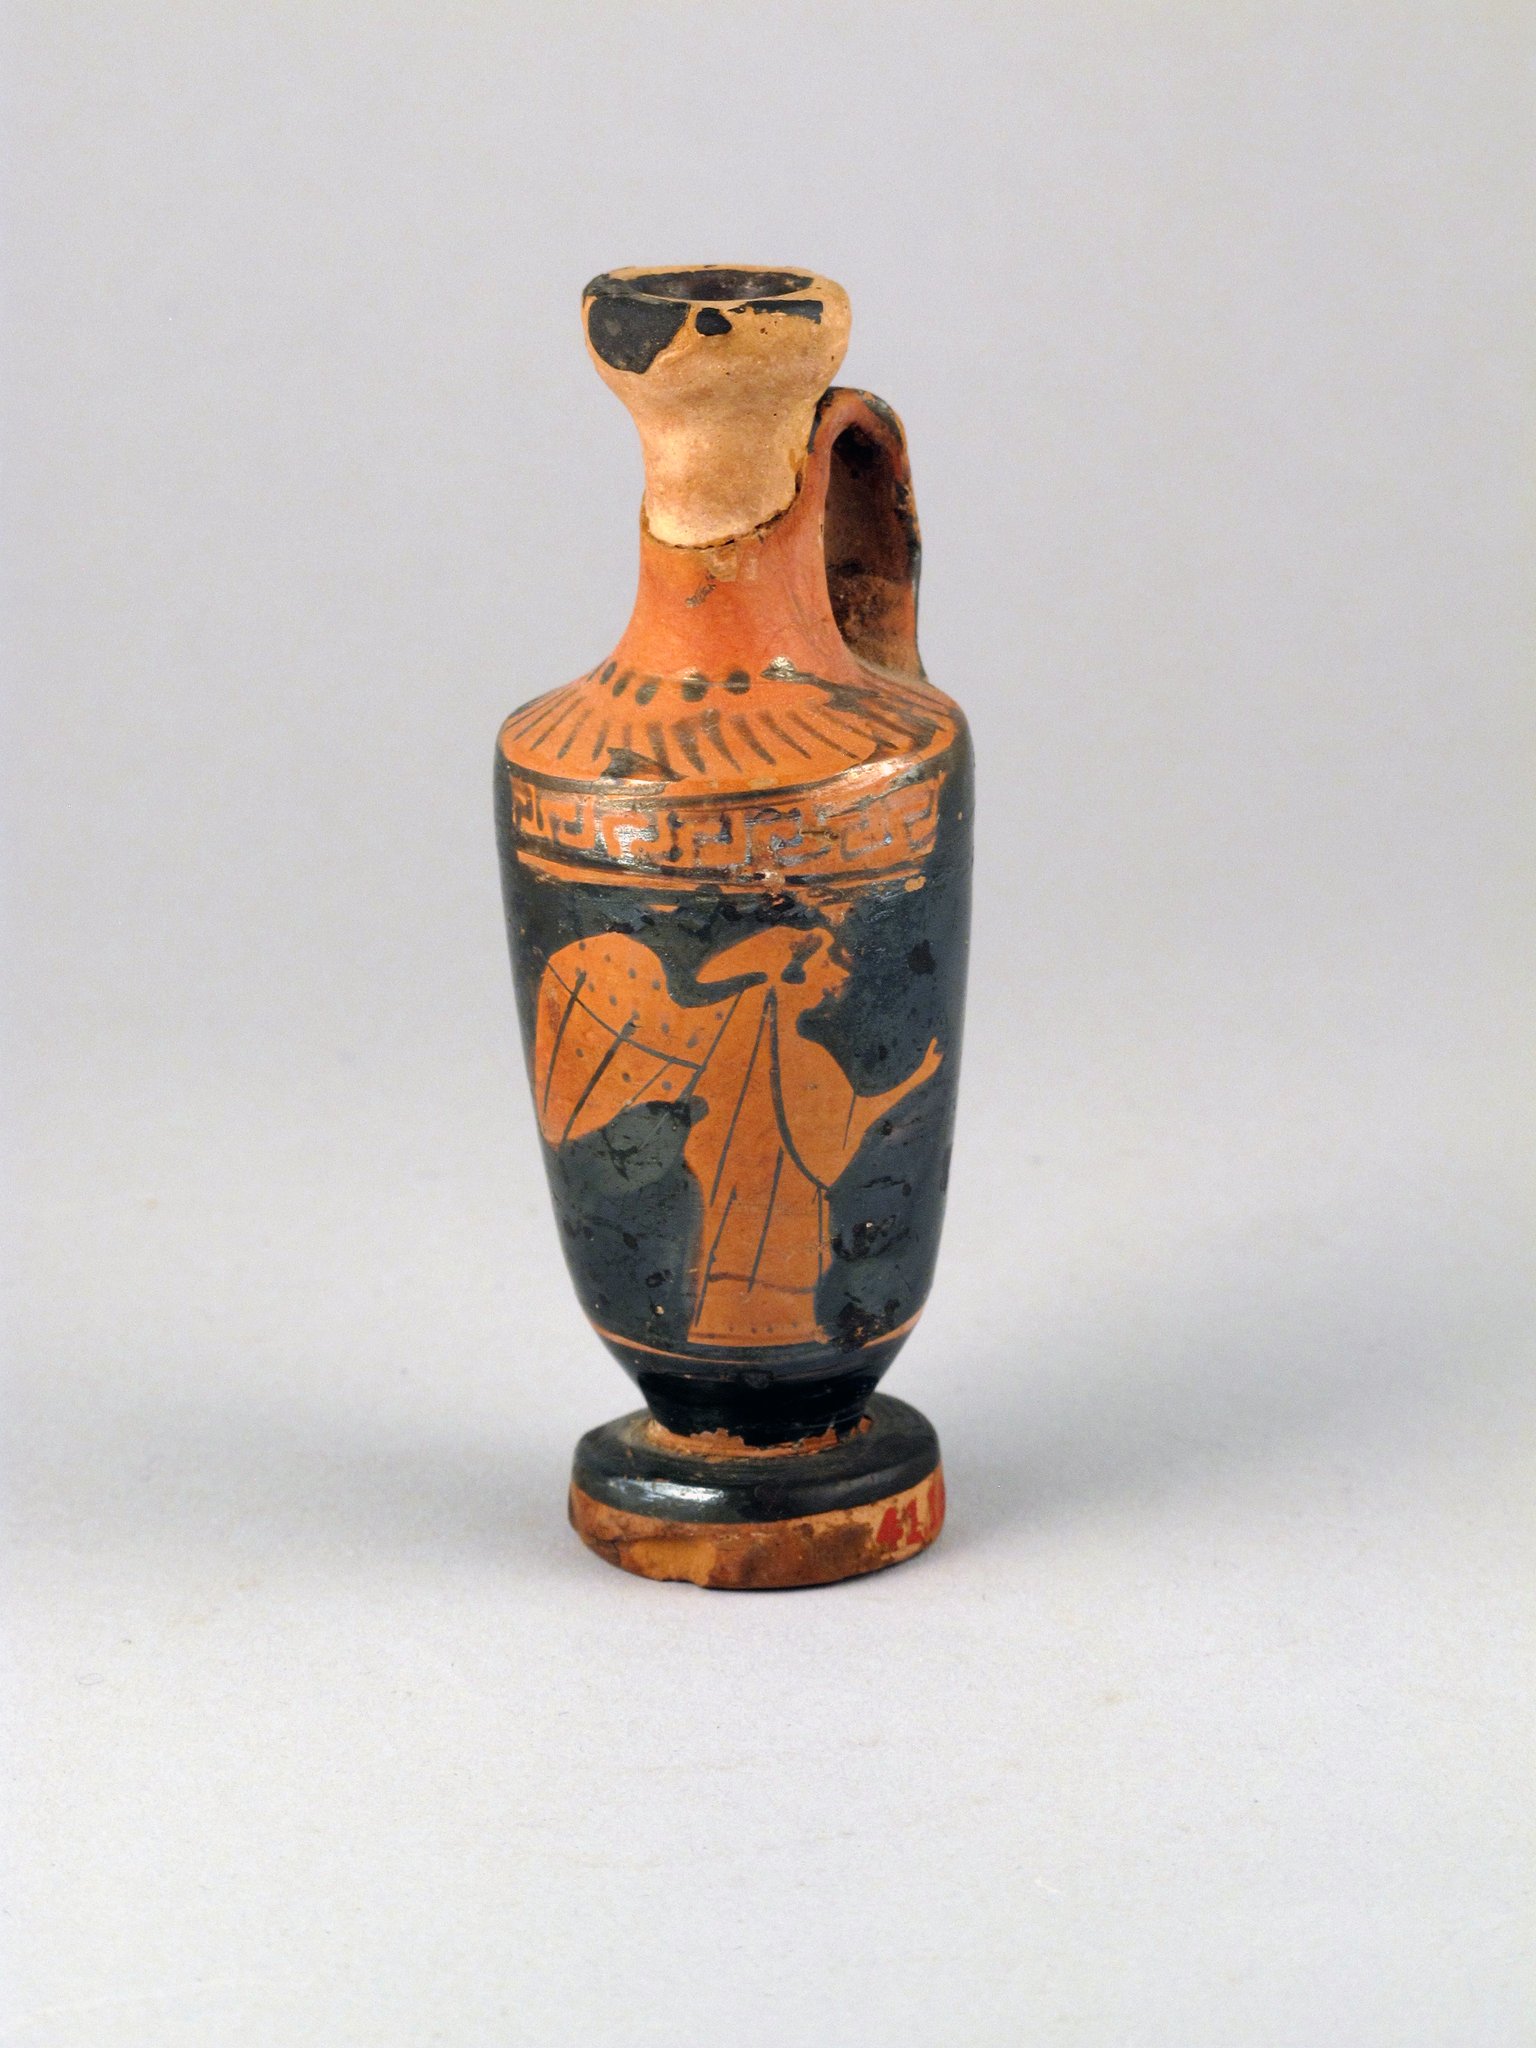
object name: lekythos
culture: greek, attic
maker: angers painter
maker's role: artist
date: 467-435 BCE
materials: terracotta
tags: nike